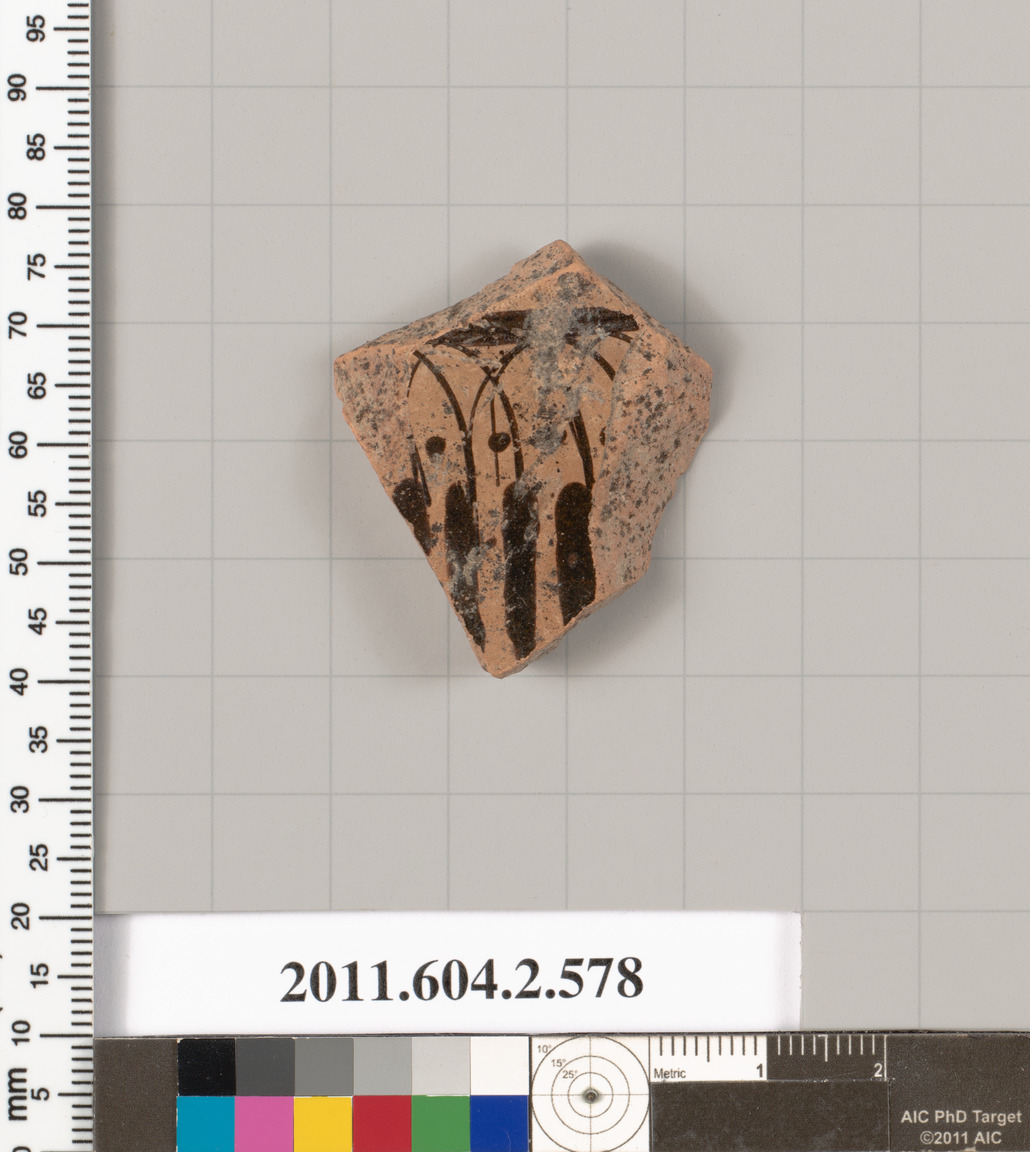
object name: column krater fragment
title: Terracotta fragment of a column-krater (bowl for mixing wine and water)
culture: greek, attic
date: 460-440 BCE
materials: terracotta